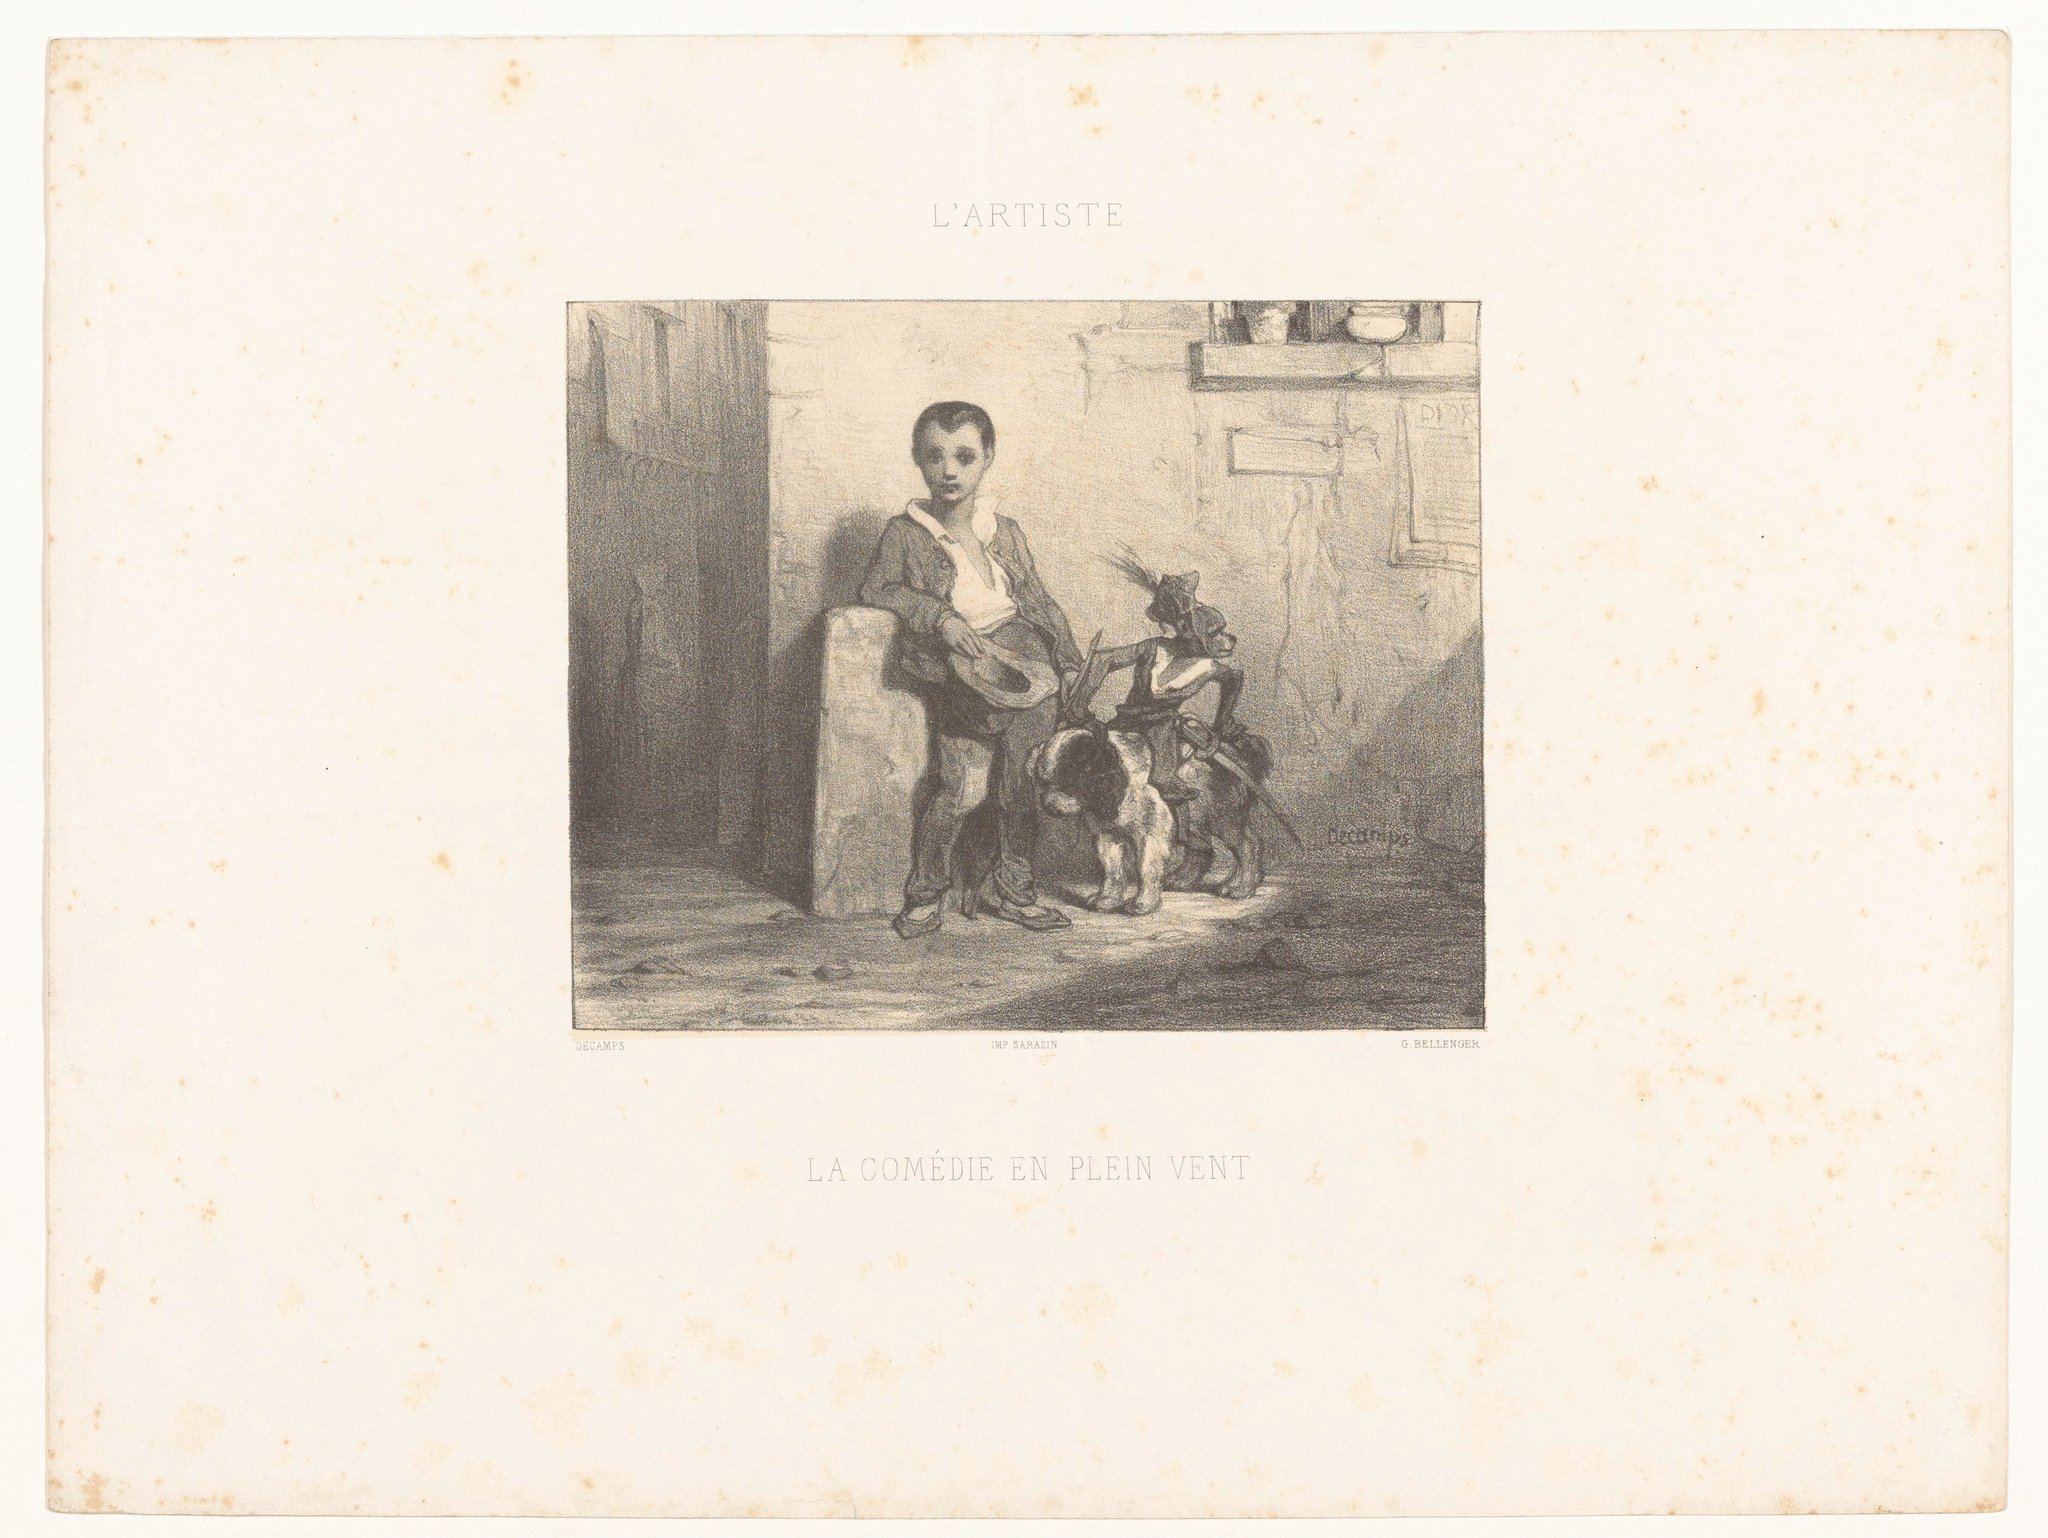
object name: print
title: Jonge straatartiest met hond en aap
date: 1863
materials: paper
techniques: lithograph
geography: paris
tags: boy (child between toddler and youth), earning money with monkey, dog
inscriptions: collector's mark: Lugt 2228a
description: Prent gepubliceerd in 'L'Artiste, journal de la littérature et des beaux-arts', een geïllustreerd weekblad dat verscheen tussen 1831 en 1904.